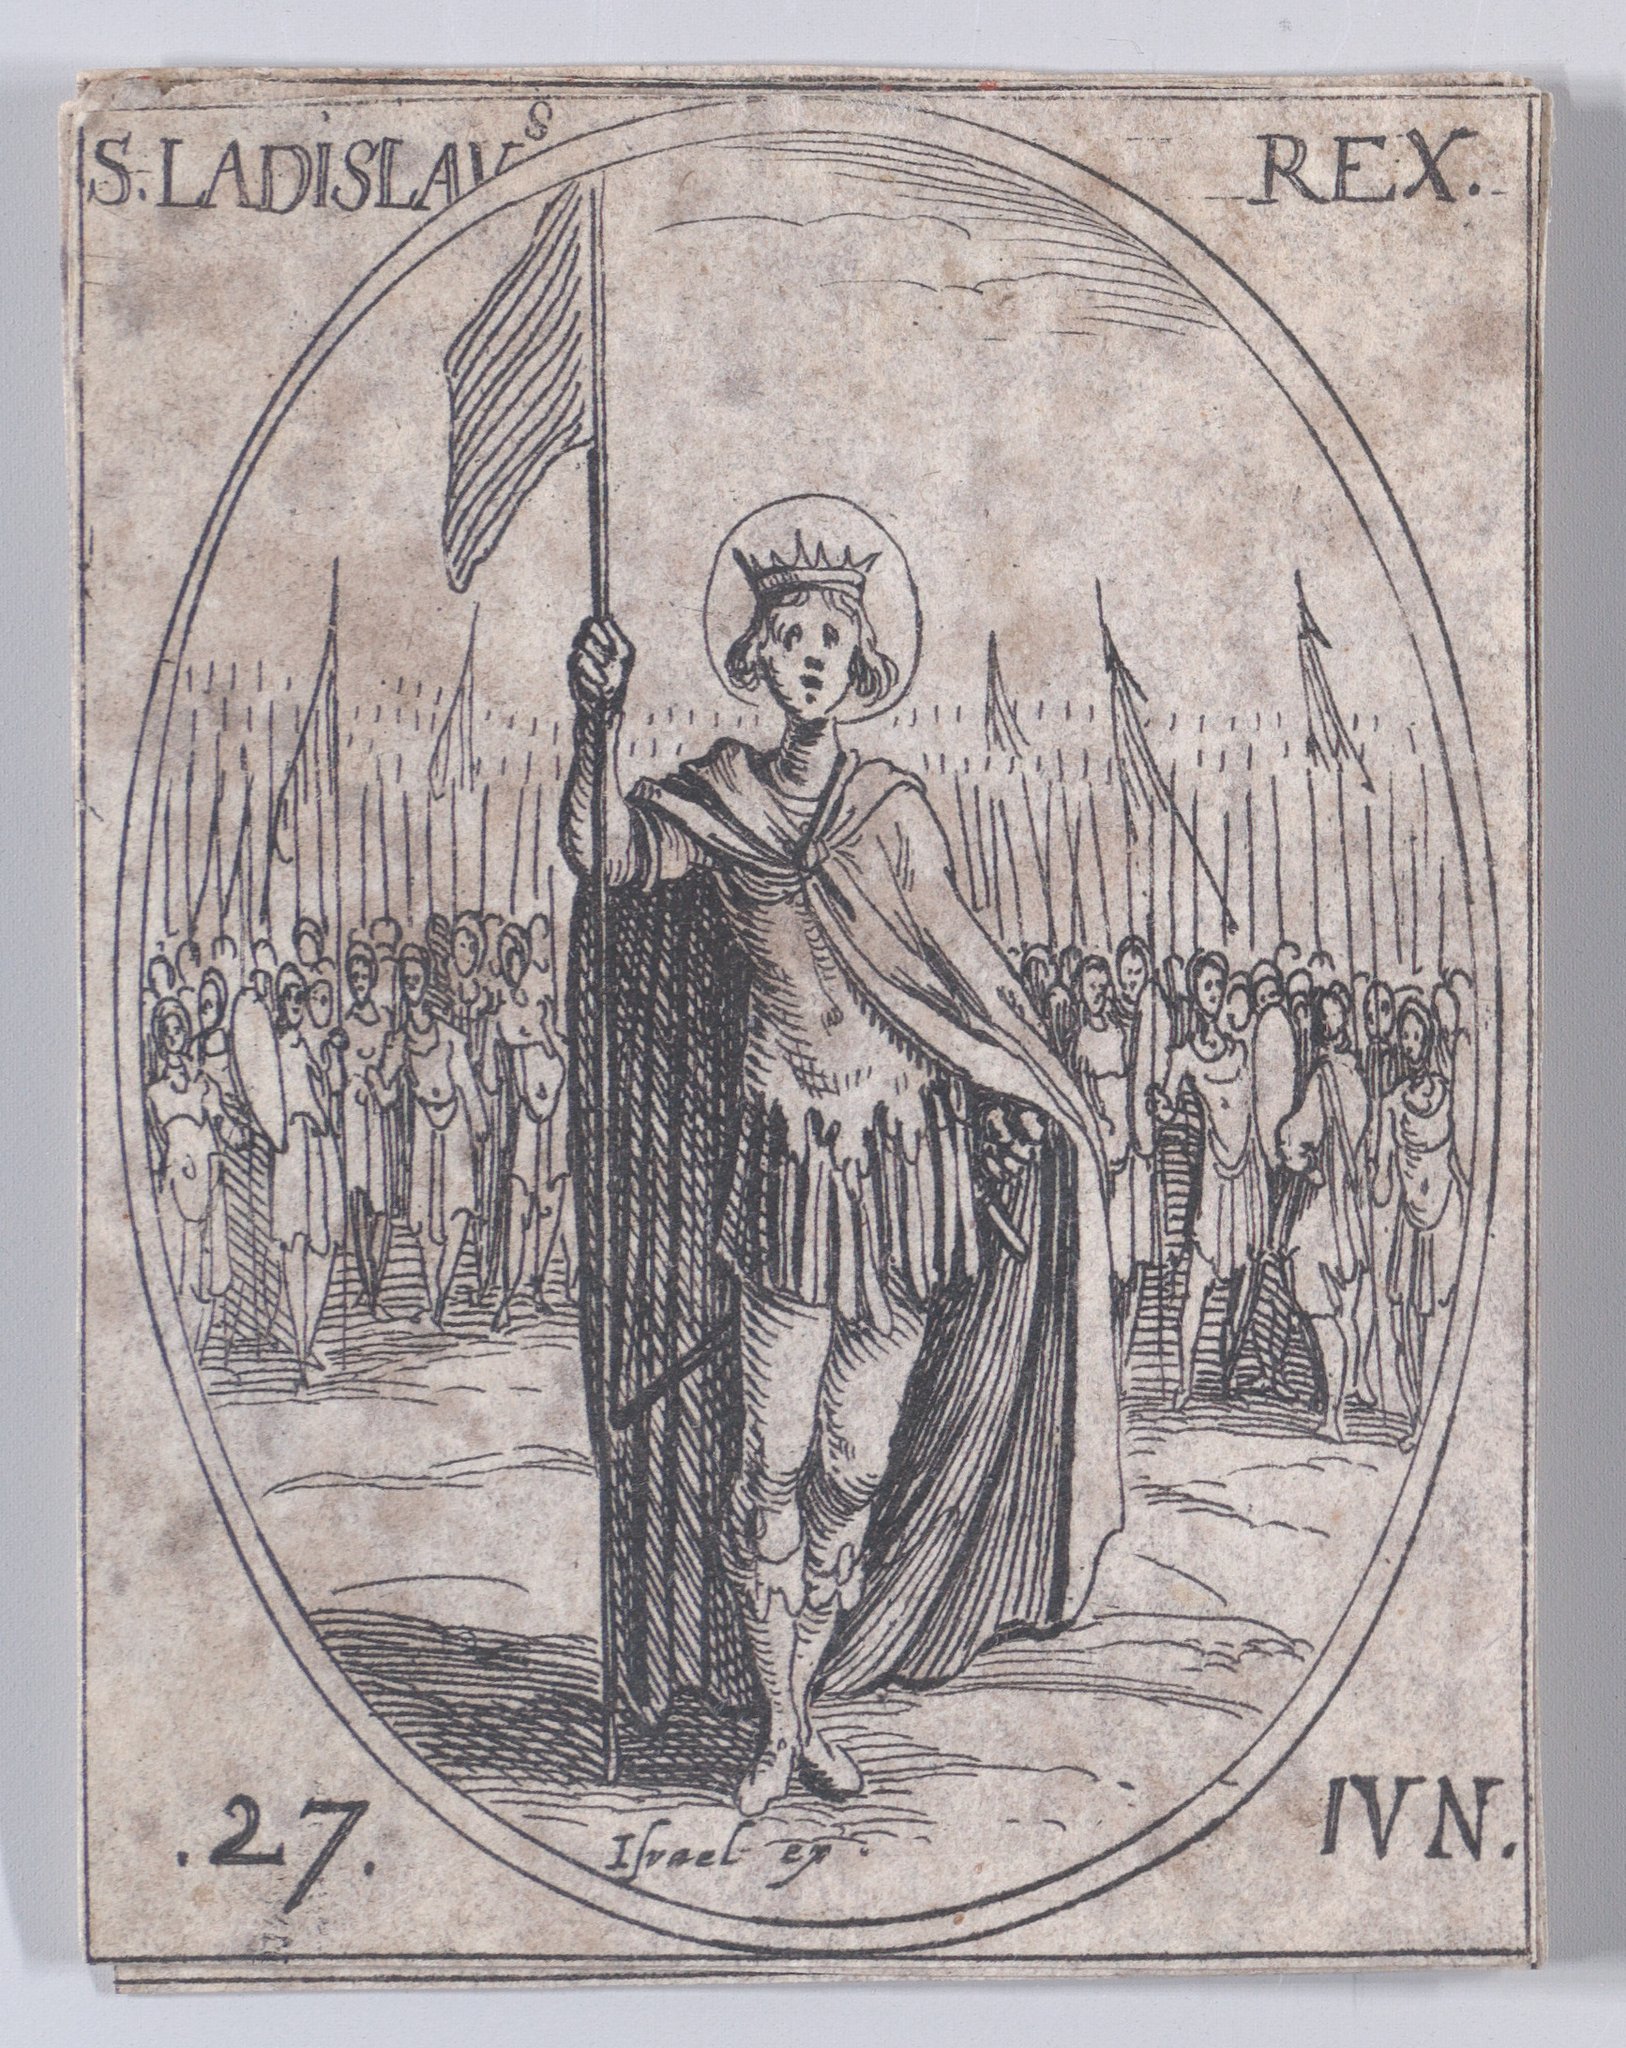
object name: print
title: S. Ladislas, roi (St. Ladislaus, King), June 27th, from Les Images De Tous Les Saincts et Saintes de L'Année (Images of All of the Saints and Religious Events of the Year)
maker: jacques callot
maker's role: artist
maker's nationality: french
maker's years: 1592-1635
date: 1636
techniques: etching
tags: men,saints